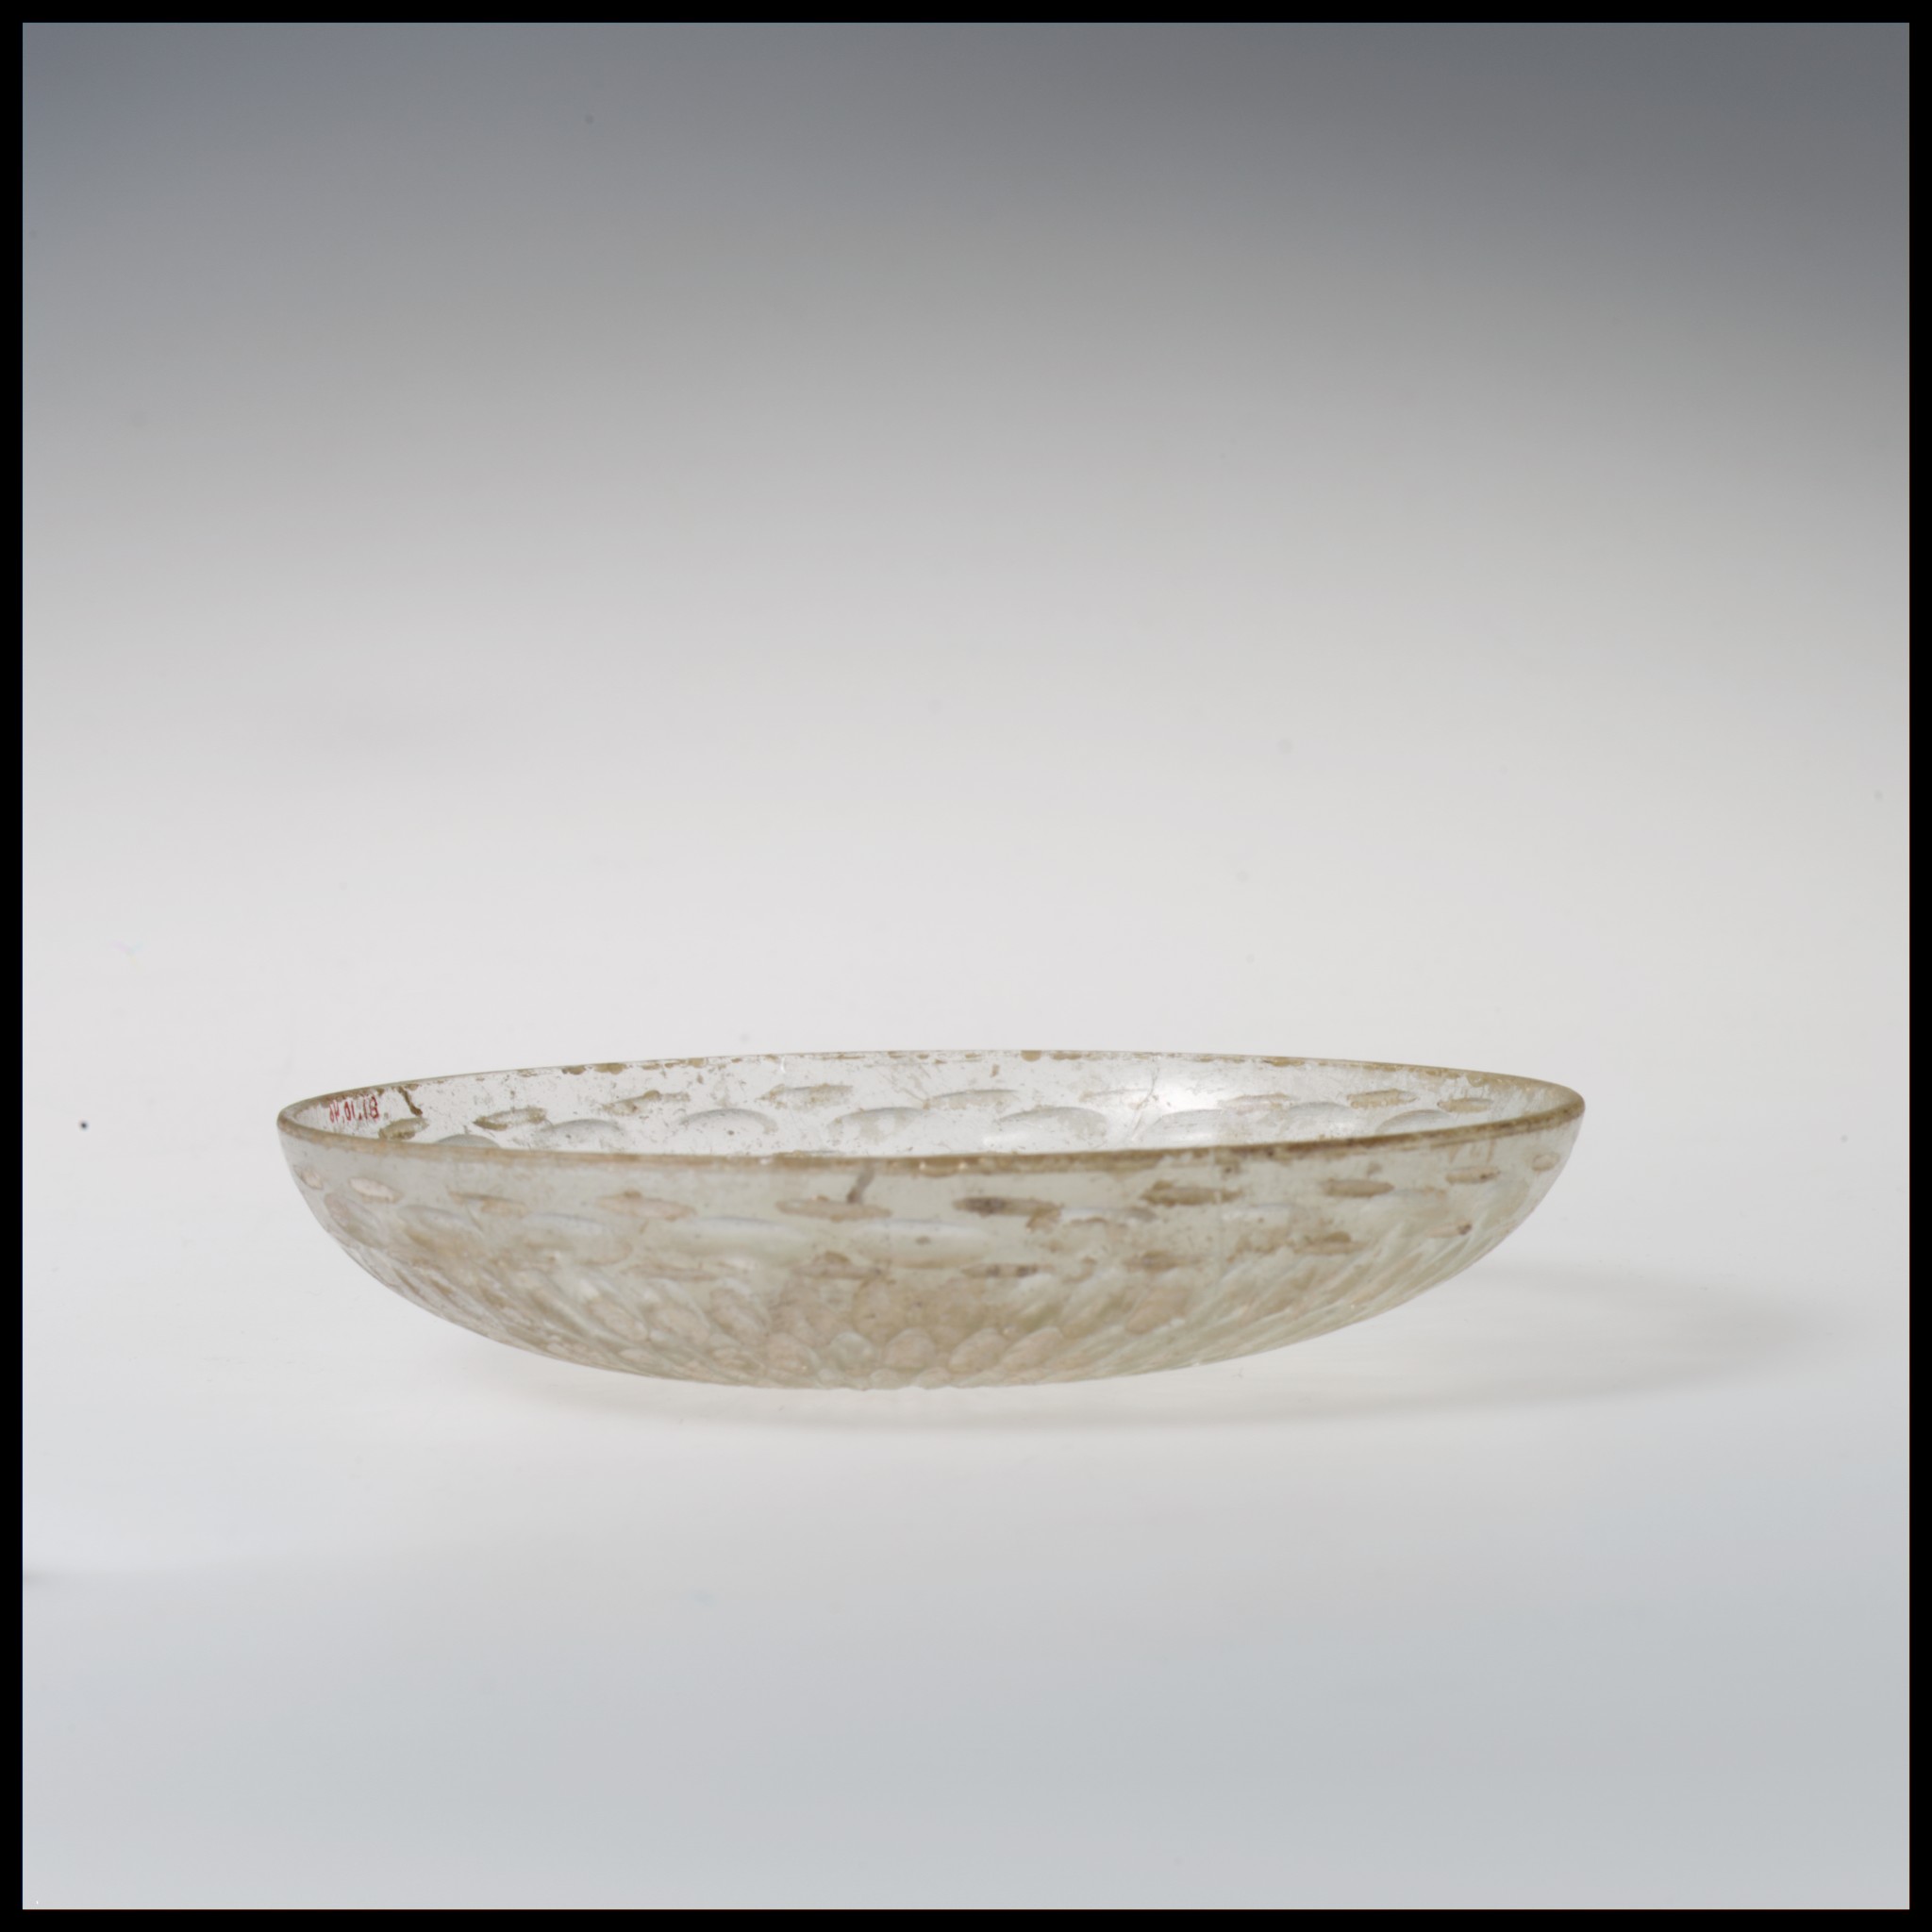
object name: bowl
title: Glass bowl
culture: roman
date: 201-400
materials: glass